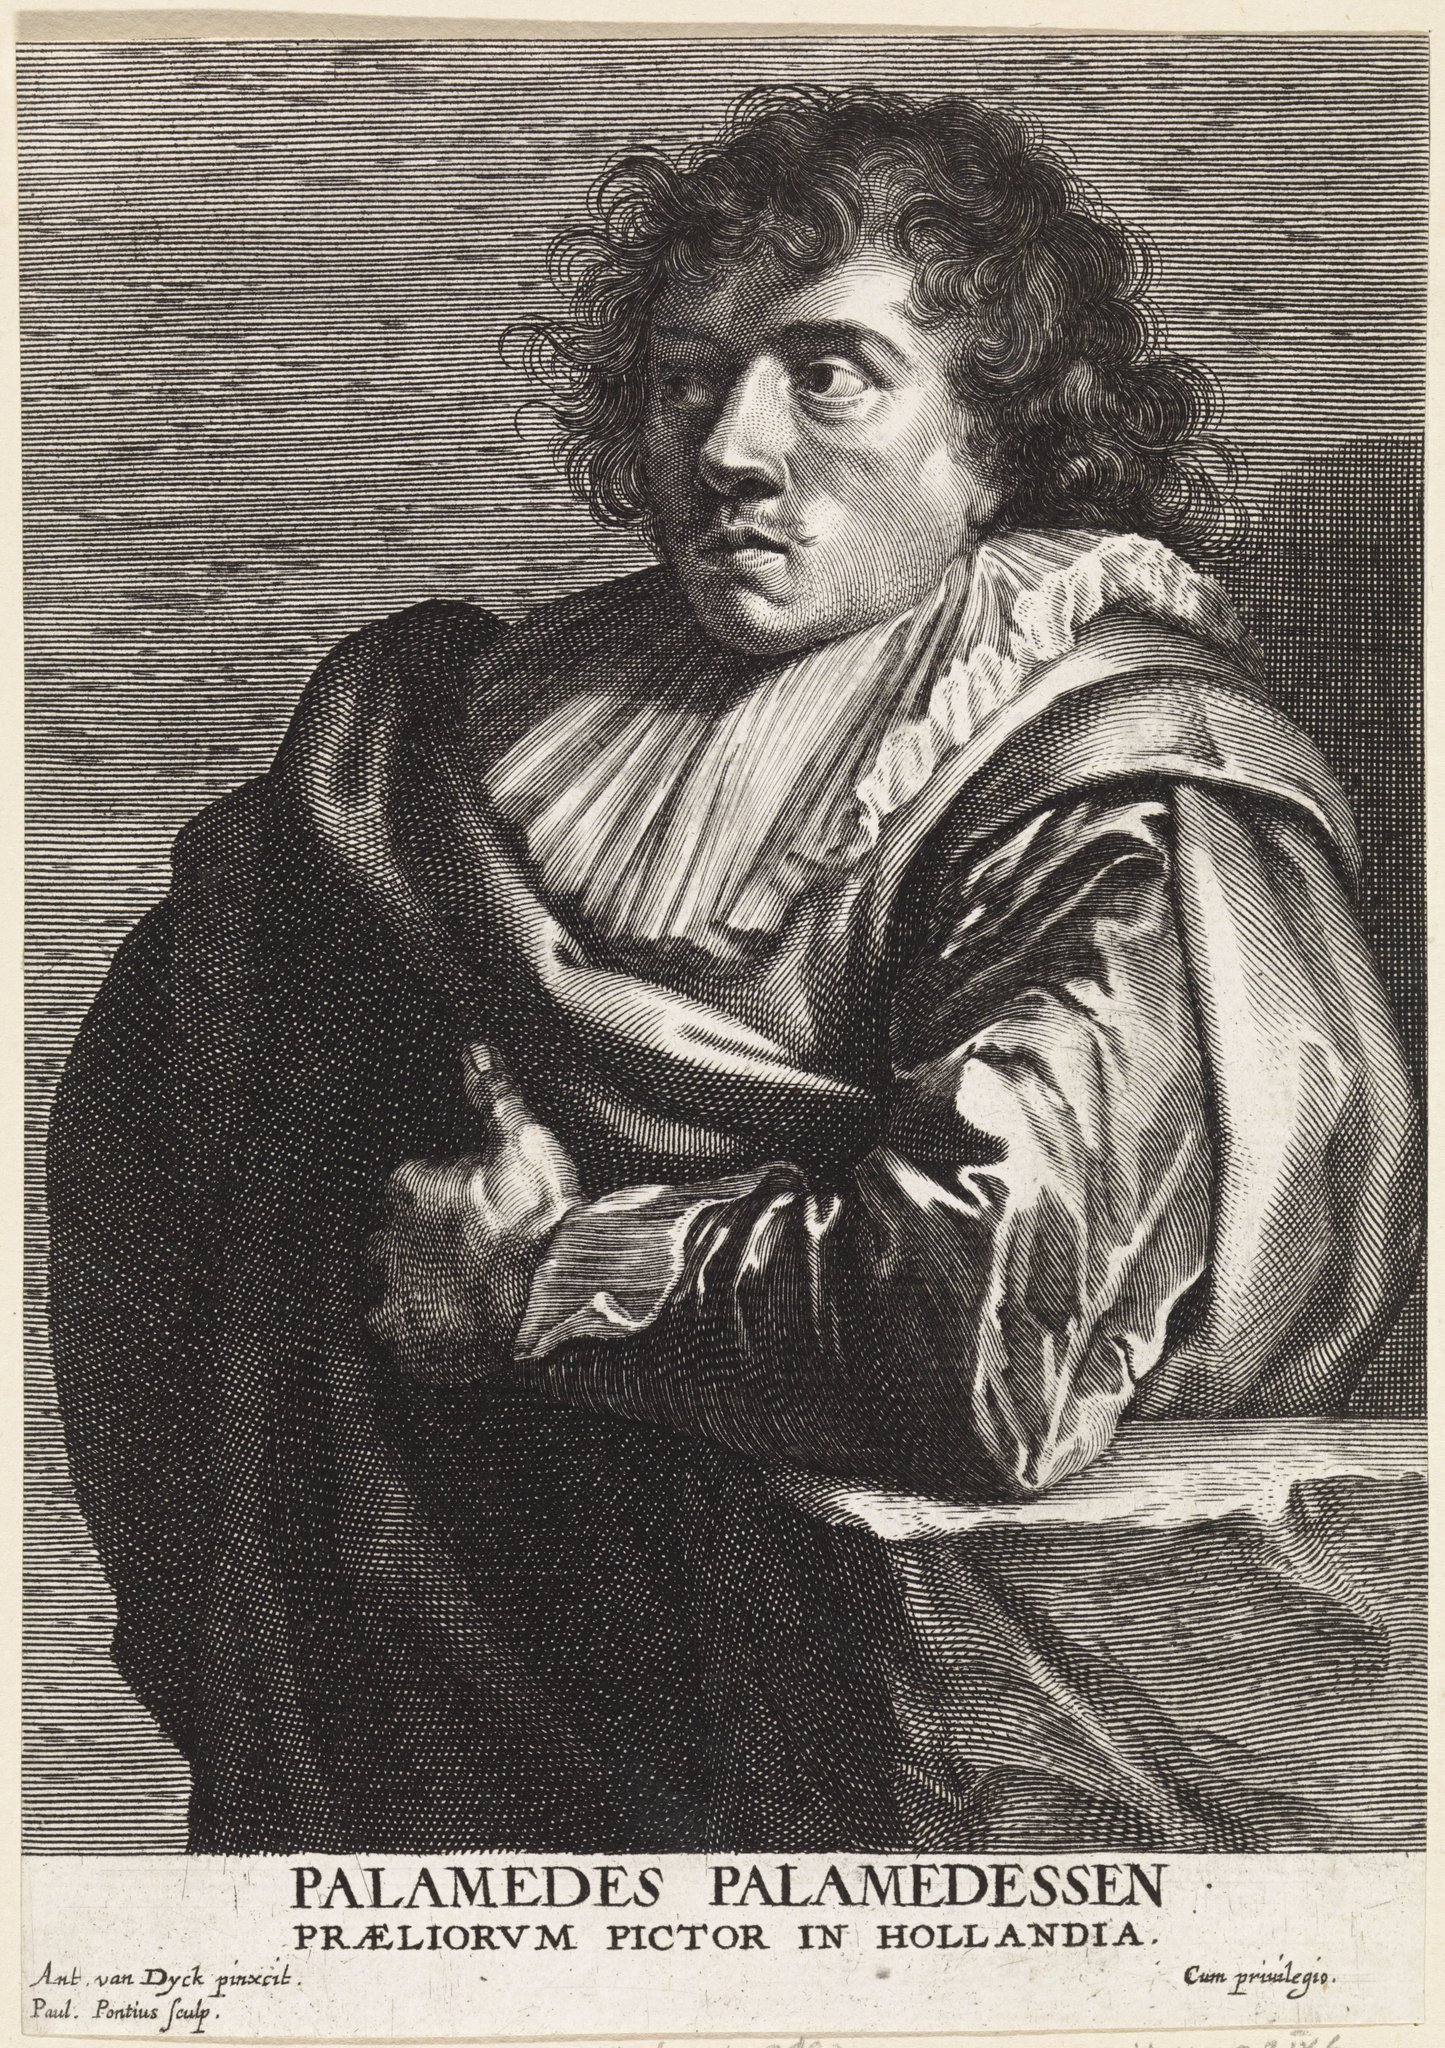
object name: print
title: Portret van Palamedes Palamedesz. I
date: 1630-1657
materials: paper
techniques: engraving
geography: antwerp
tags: painter, palamedes palamedesz. (i), historical persons, portrait, self-portrait of painter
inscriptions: collector's mark: Lugt 240